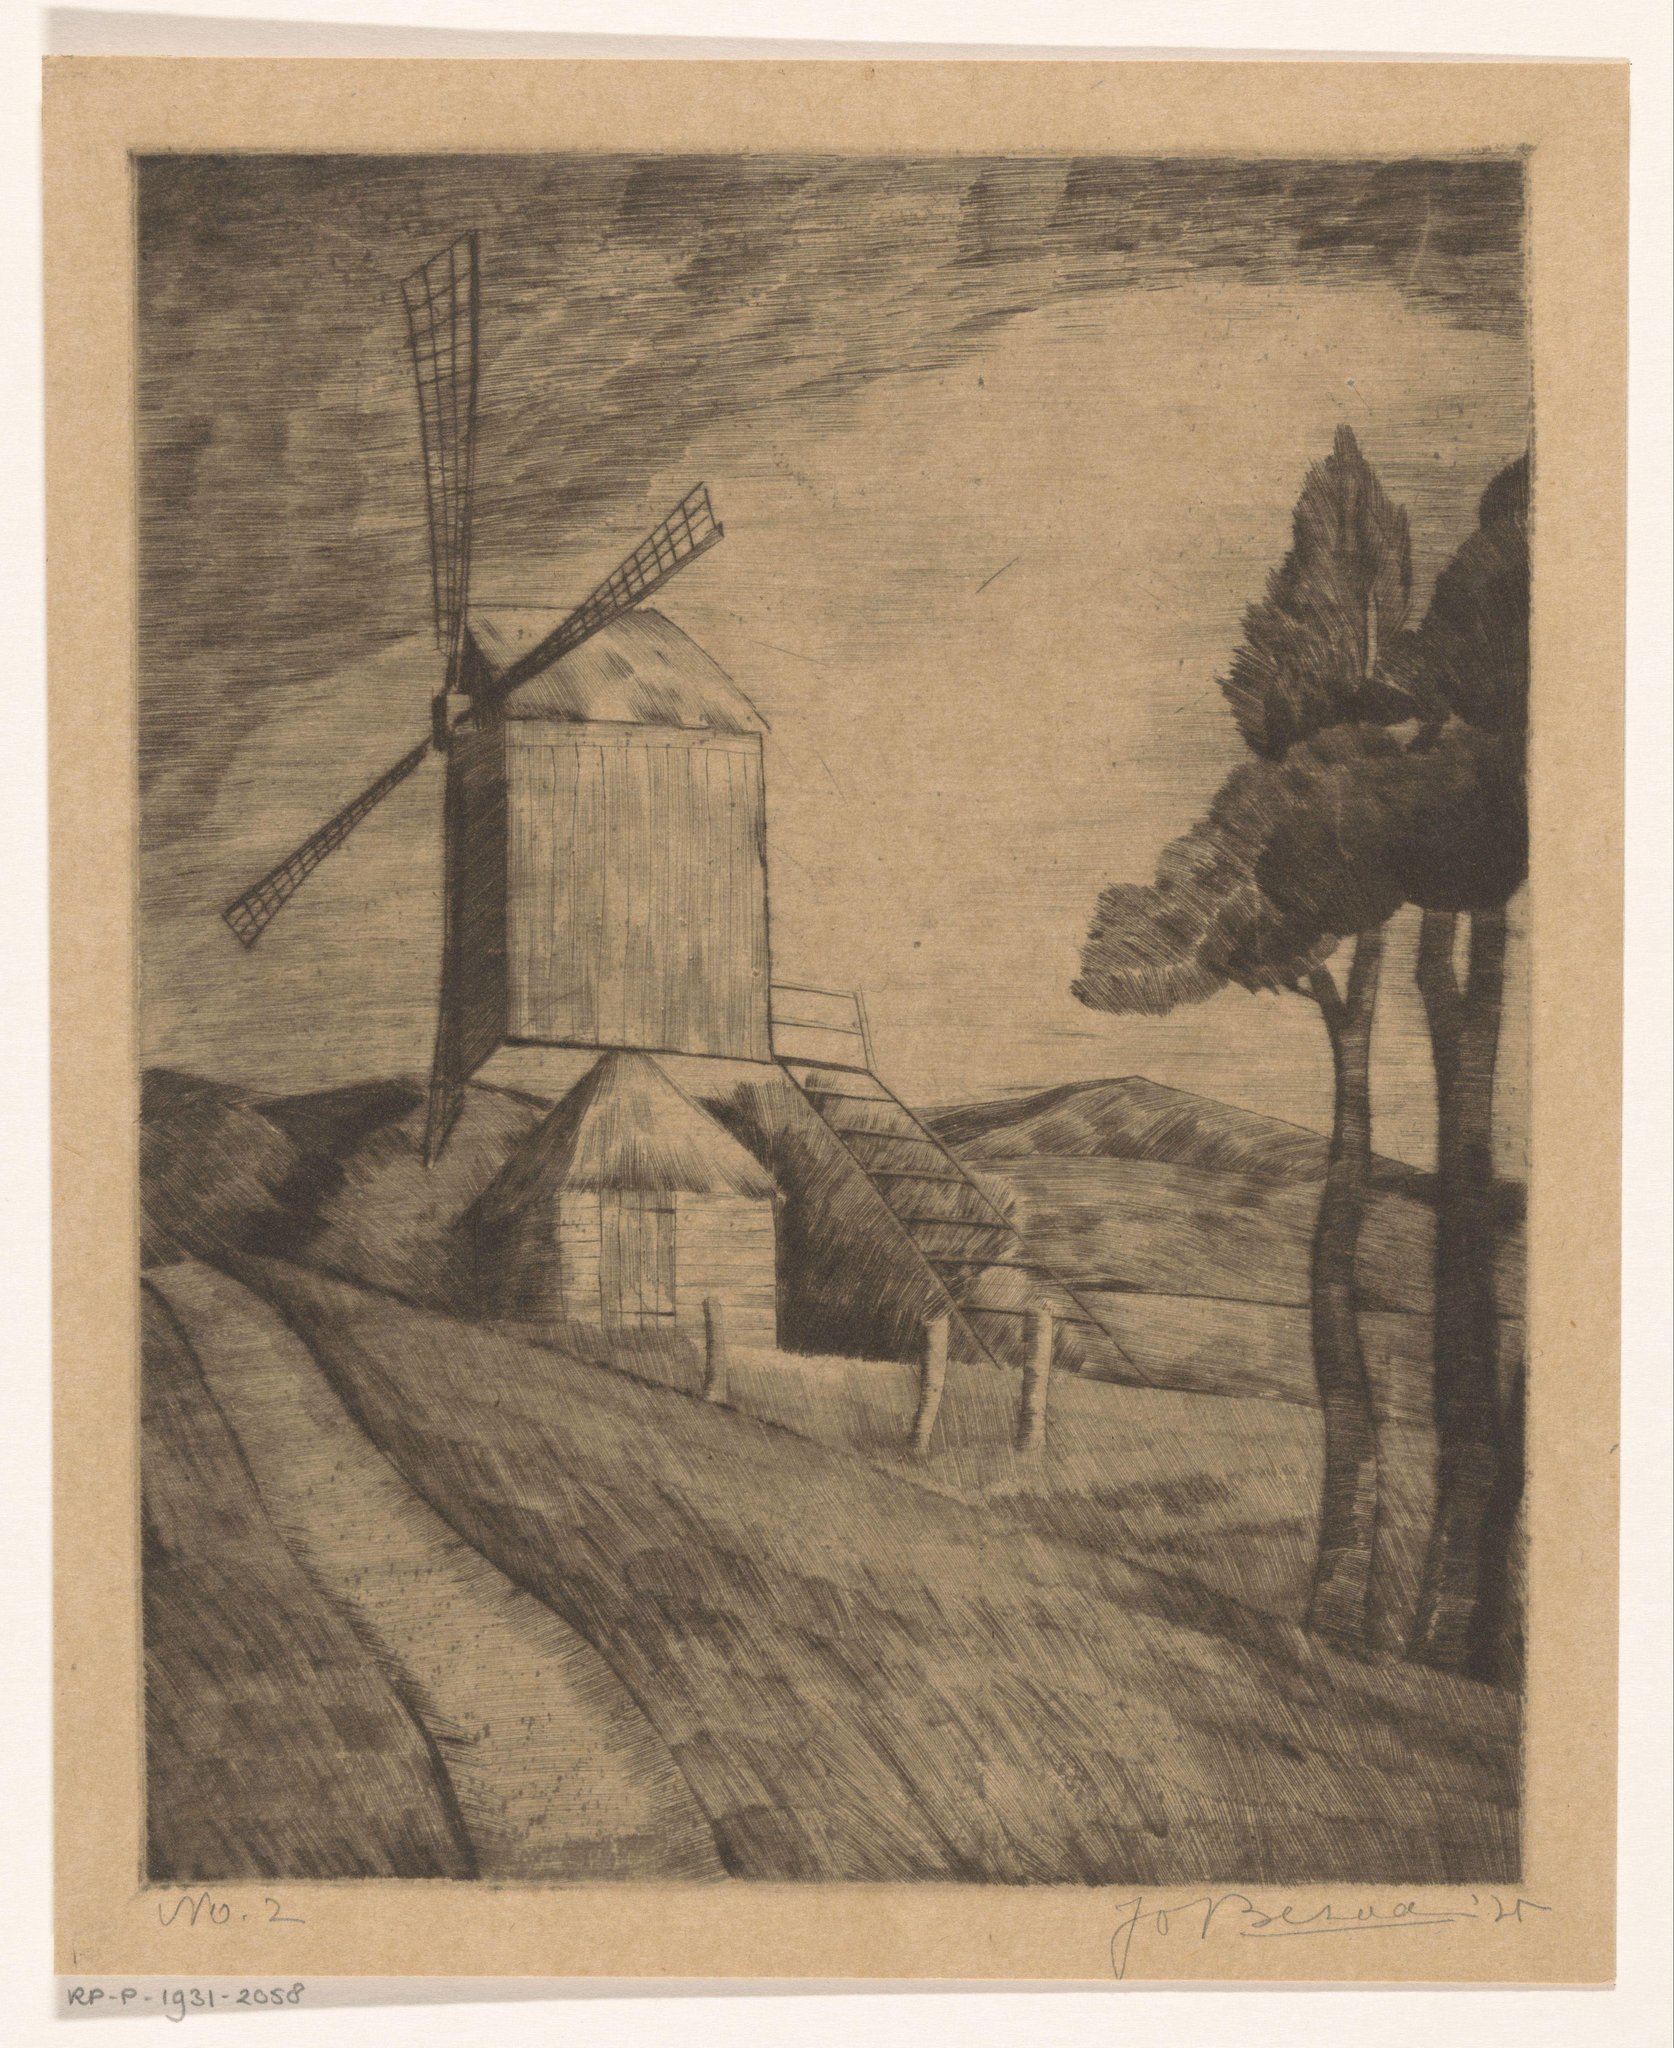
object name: print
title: Molen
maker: jo bezaan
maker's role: draughtsman, print maker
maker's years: 1894-1952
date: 1925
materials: paper, ink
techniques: drypoint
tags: windmill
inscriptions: signature and date: ‘Jo Bezaan ´25’, edition: ‘No. 2’, collector's mark: Lugt 2228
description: Gezicht op een molen met daarvoor een vierkant huisje.